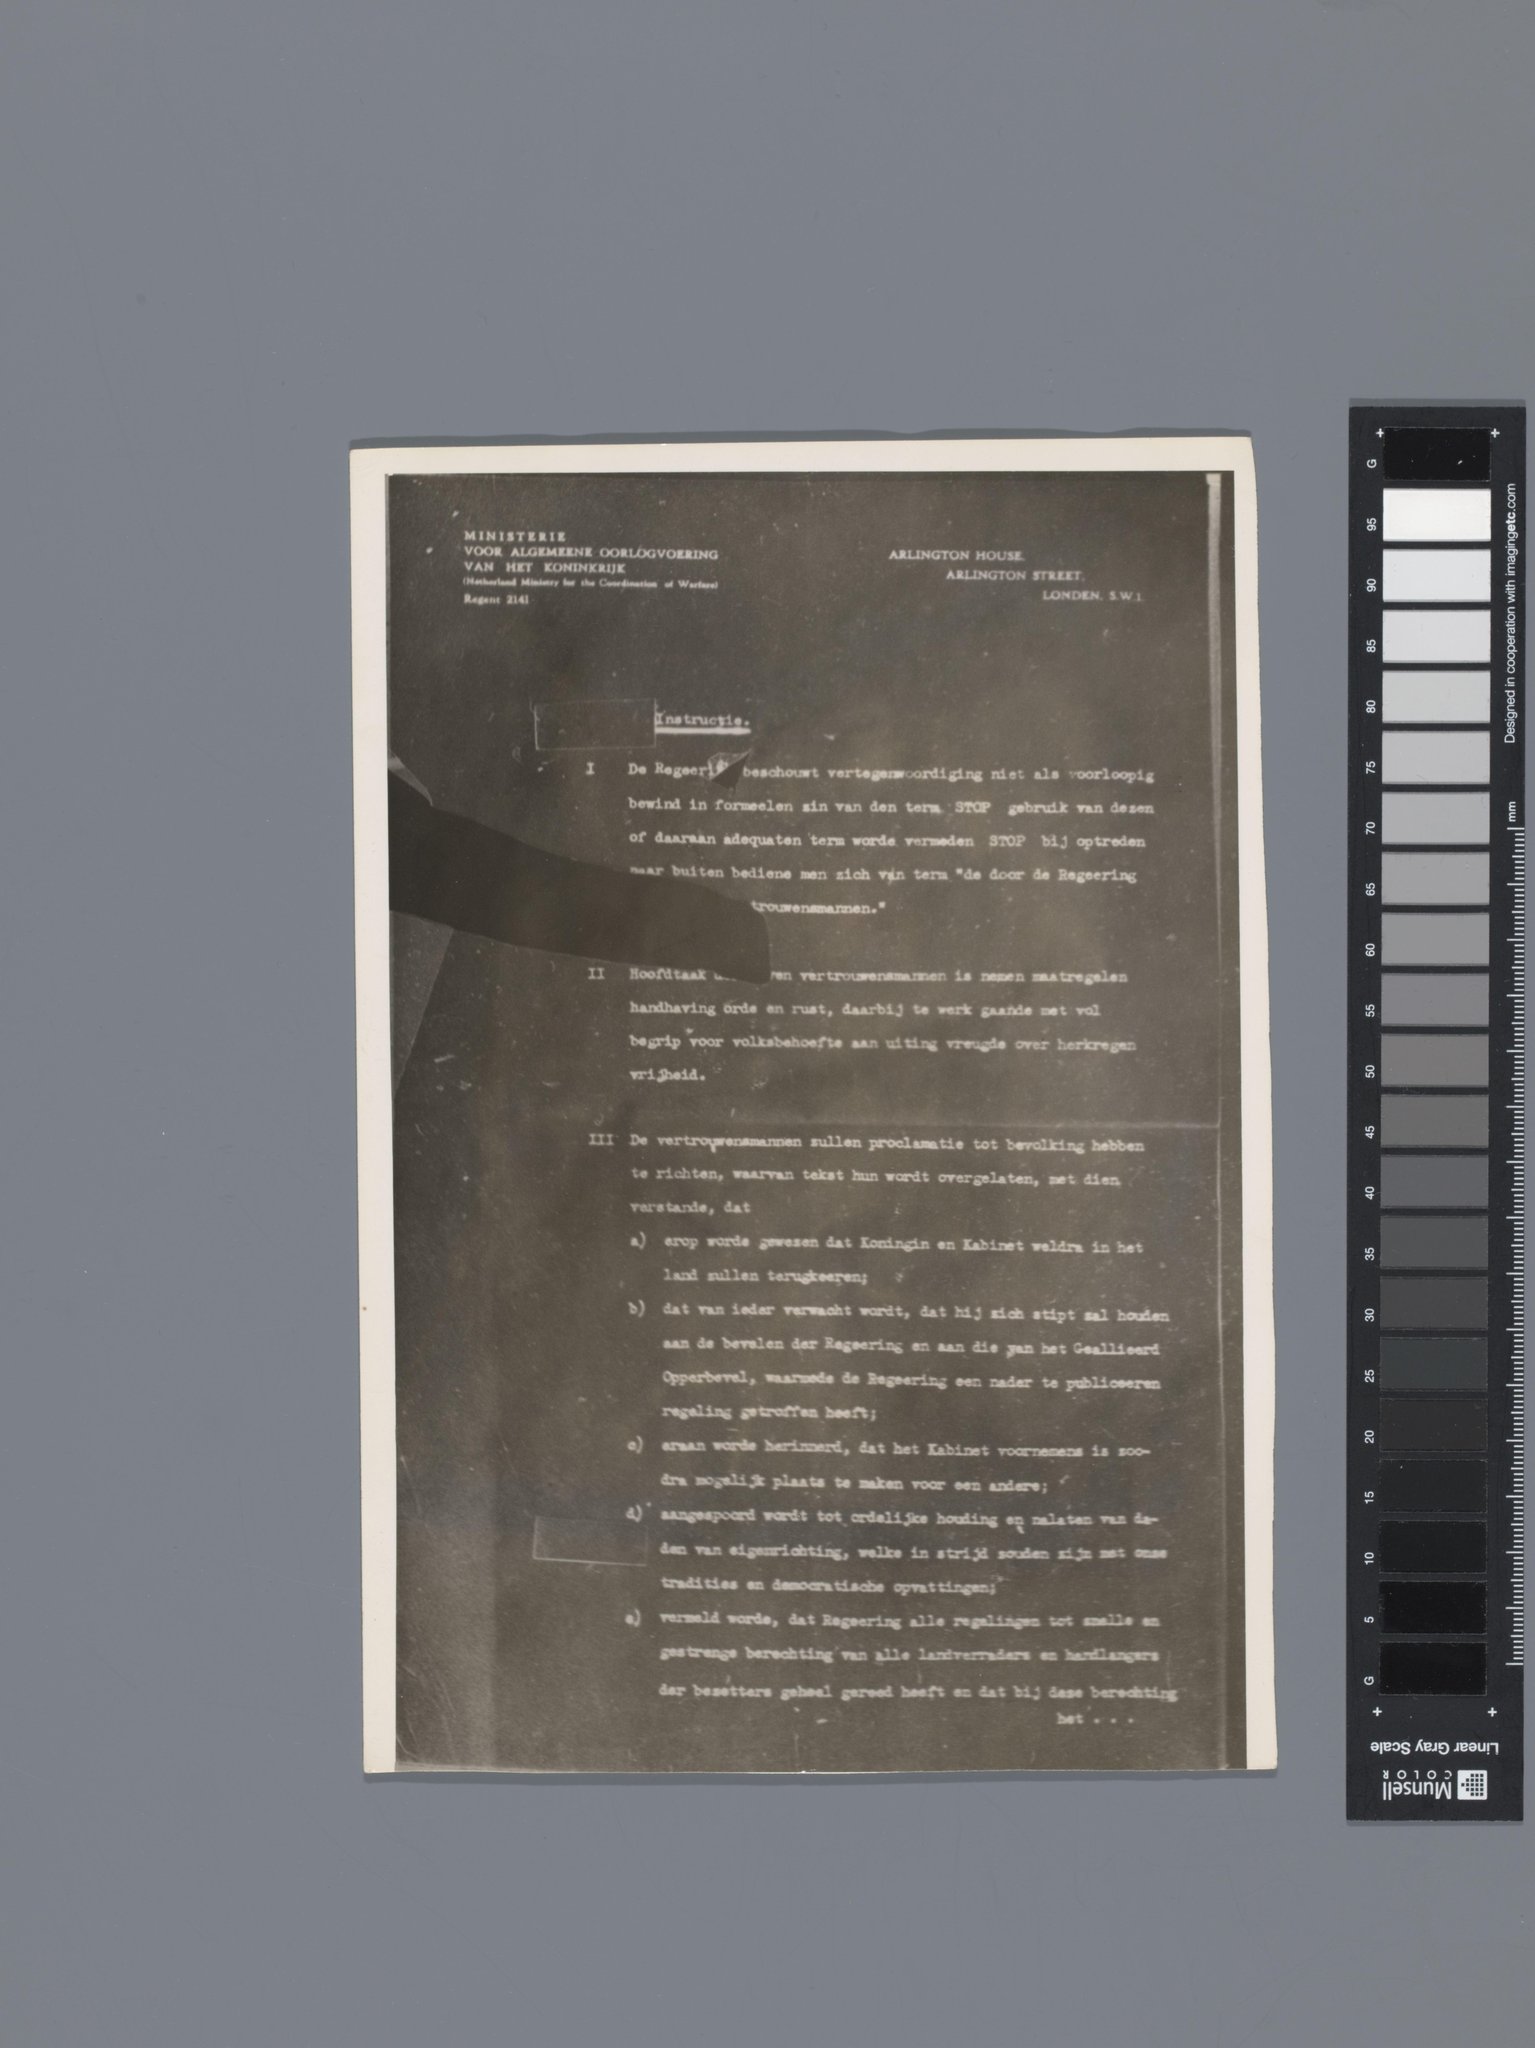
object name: photograph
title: Nederlandse regering in Londen in ballingschap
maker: pieter sjoerds gerbrandy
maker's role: minister van staat, tweede kamerlid, hoogleraar, lid tweede kamer, minister-president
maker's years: 1885-1961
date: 1944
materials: photographic support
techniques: photography, typewriting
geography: london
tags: the hague, pieter sjoerds gerbrandy, willem drees, netherlands, london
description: Eén foto van in totaal drie foto's van een document, afkomstig van de Nederlandse regering in Londen in ballingschap, waarbij het illegale college van vertrouwensmannen werd opgericht, dat maatregelen moest nemen voor een tijdelijk bestuur van Nederland na de bevrijding van het gehele land. Drees was lid van dit college. Opschrift; r.b.: 'Arlington House, Arlington Street, Londen, SW 1'. Opmerking: Behoort bij inv. nrs. NG-685-a en c.